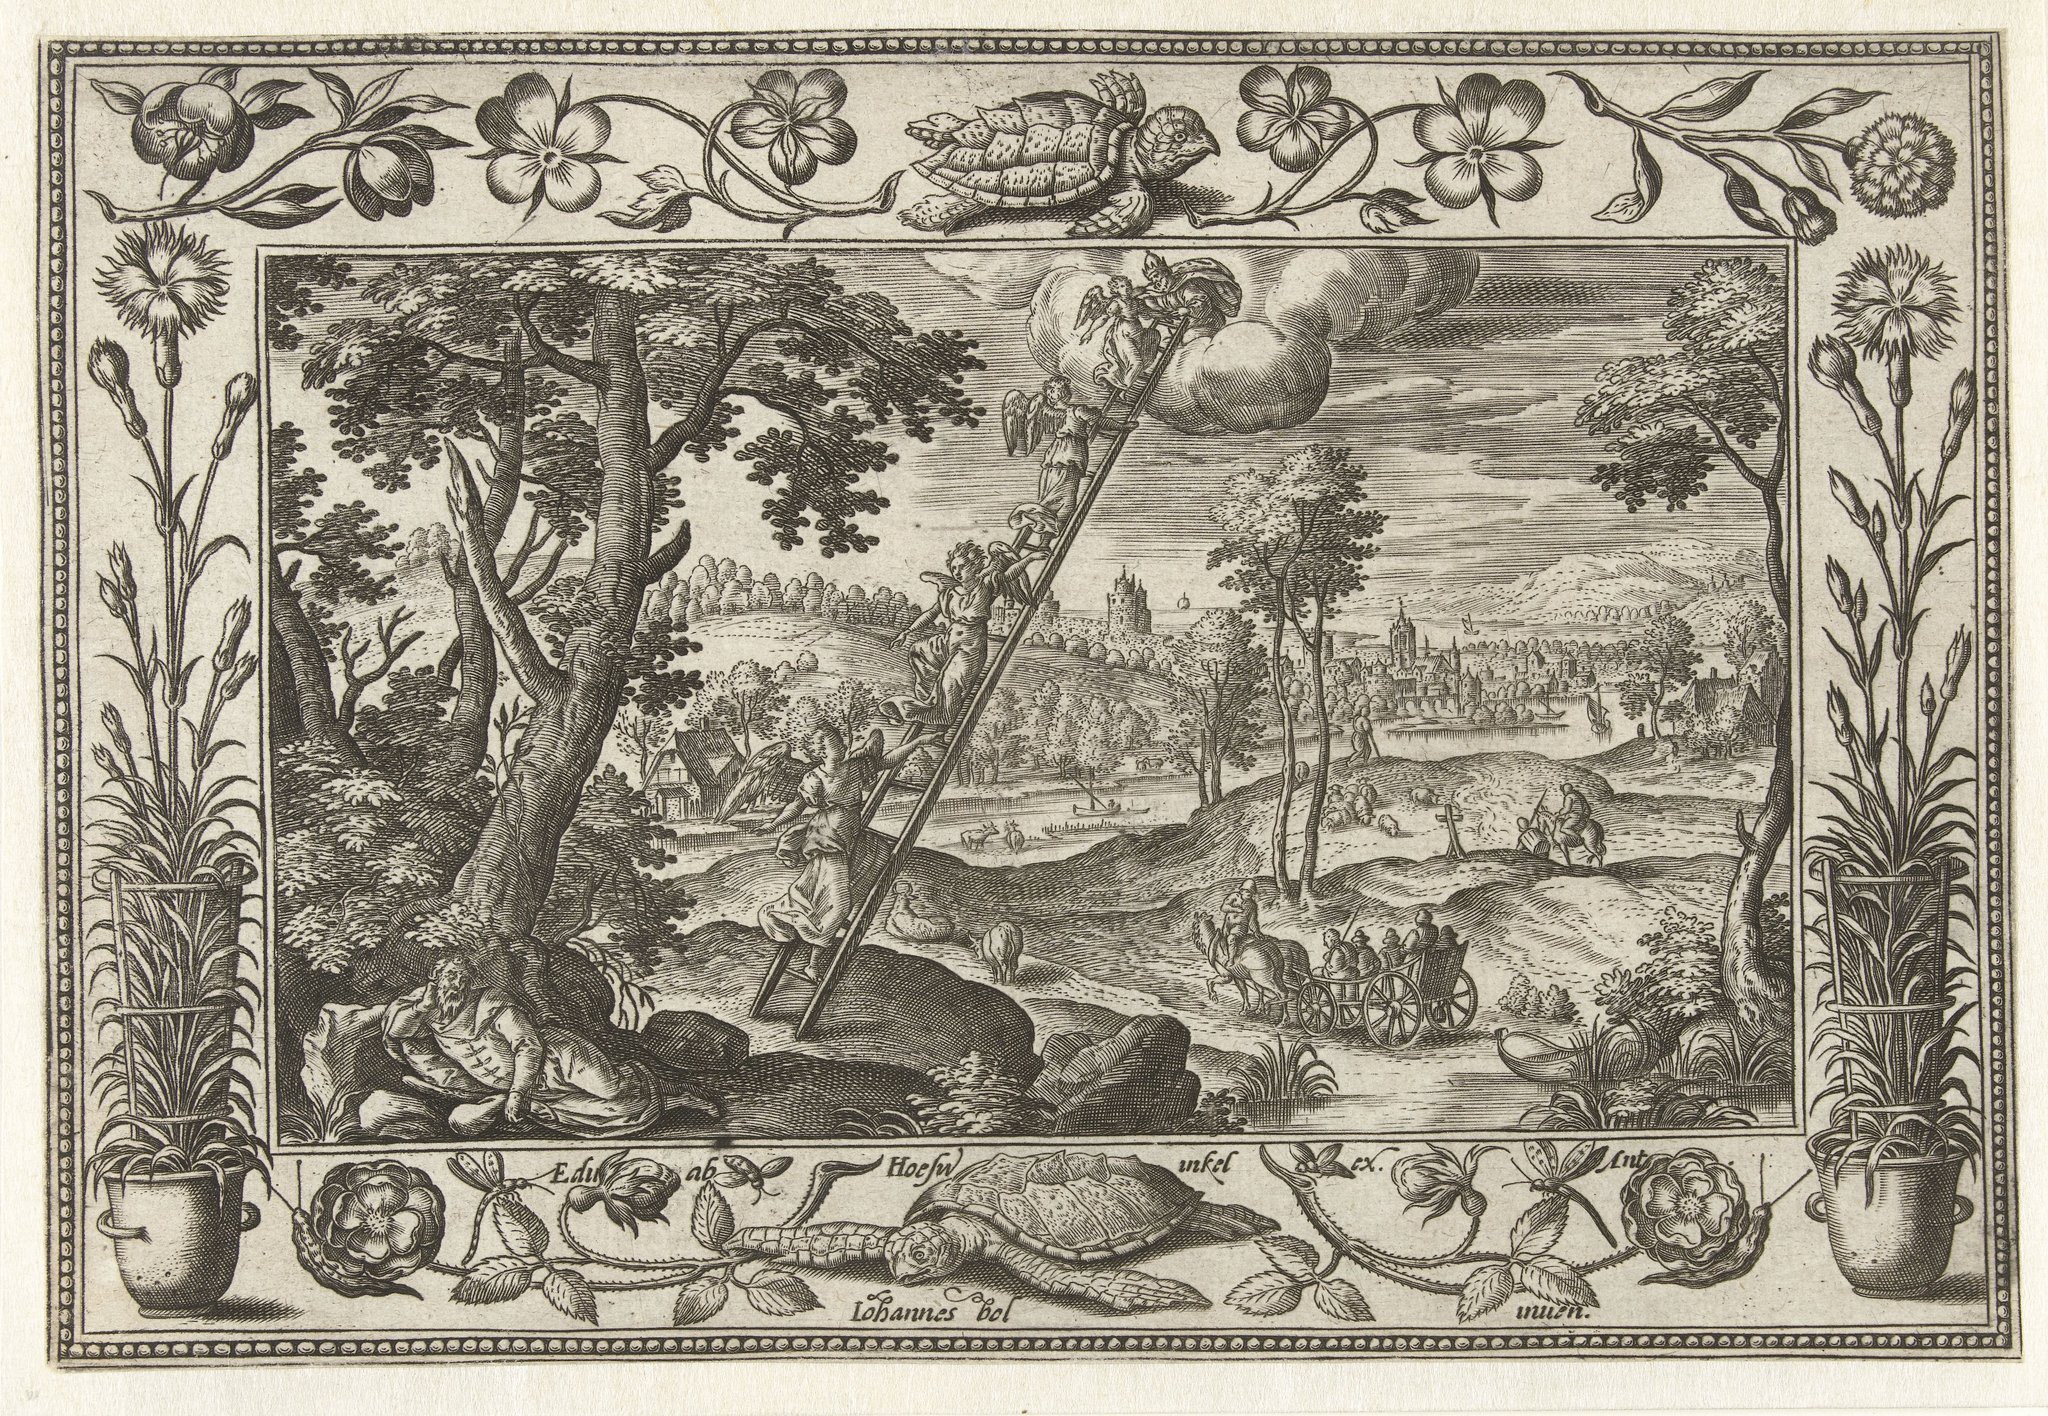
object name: print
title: Jakobs ladder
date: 1582-1586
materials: paper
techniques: engraving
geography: antwerp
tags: river, the dream of jacob: while sleeping on the ground with a stone for pillow jacob sees a ladder reaching from earth to heaven with angels going up and down; usually with god at the top of the ladder, tortoises, turtles (+ ornamental variants of animals), flowers ~ ornament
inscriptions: collector's mark: Lugt 2228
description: Landschap met een rivier. Op de voorgrond links de slapende Jakob. Hij droomt dat engelen vanuit de hemel via een ladder omhoog en omlaag klimmen. Boven in de wolken God de Vader. De prent heeft een ornamentlijst met bloemen en schildpadden. Hij maakt deel uit van een vierentwintigdelige serie van landschappen met Bijbelse, mythologische scènes en jachttaferelen.